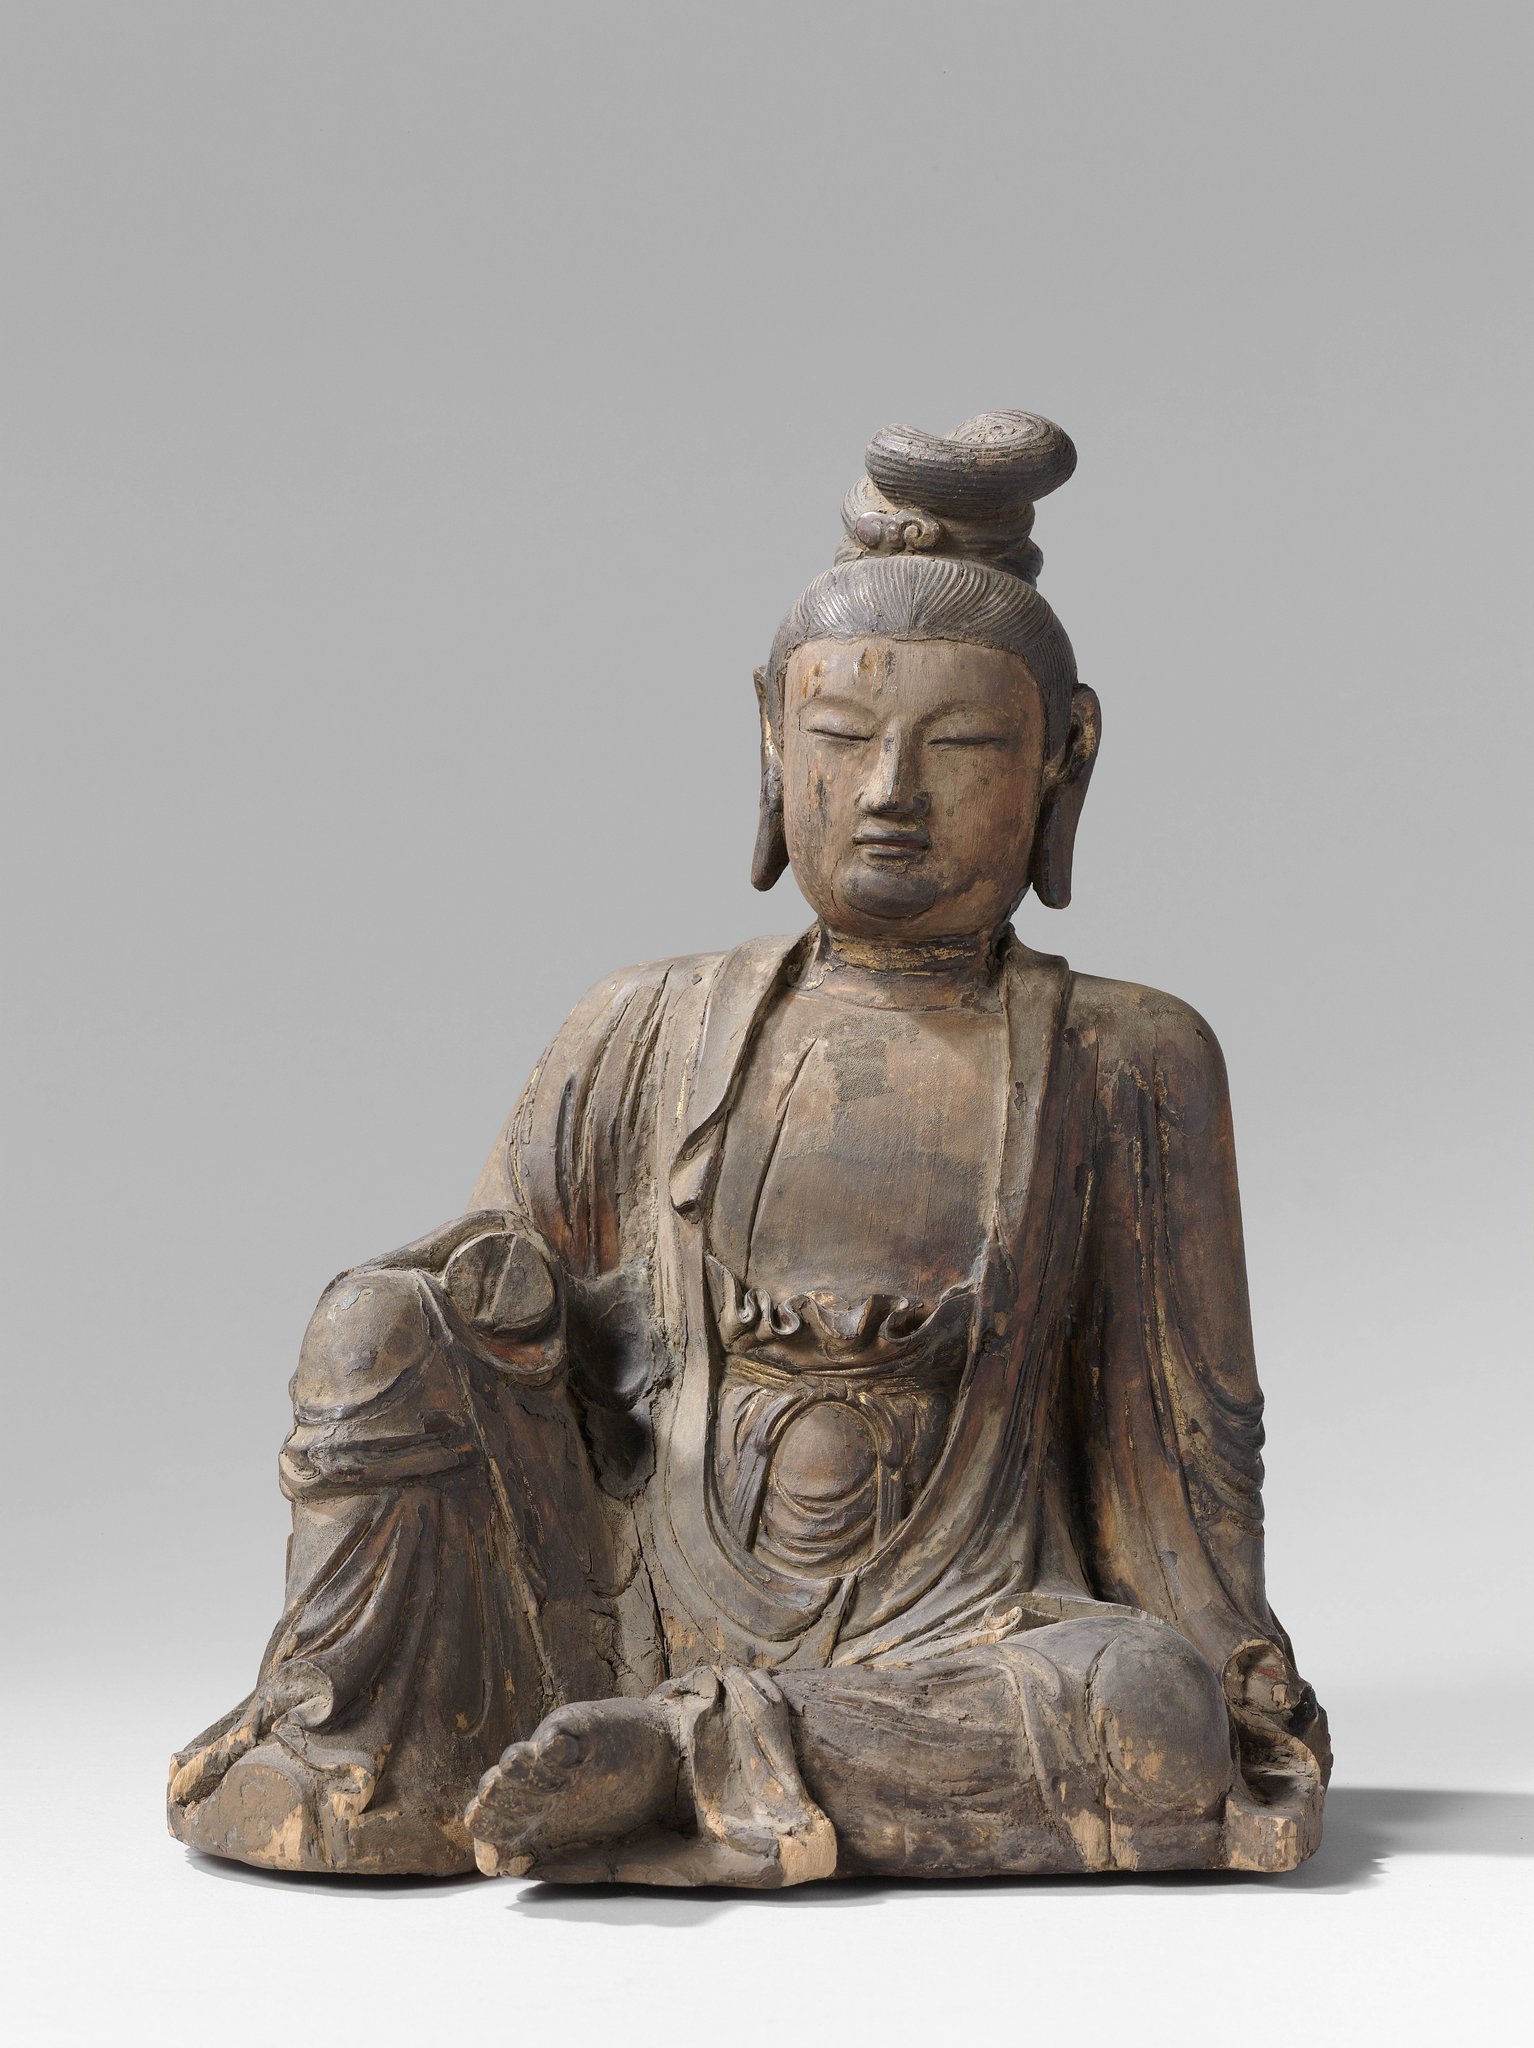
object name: sculpture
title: Bodhisattva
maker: Anonymous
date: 1100-1300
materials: wood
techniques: gilding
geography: china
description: This bodhisattva sits in the so-called Maharajajila posture of royal ease, one arm resting on a raised knee. This pose also suggests that this figure is a so-called Water-Moon Guanyin, in which form the divinity contemplates the reflection of the moon in the water. This portrayal first originated in China in the 10th century.